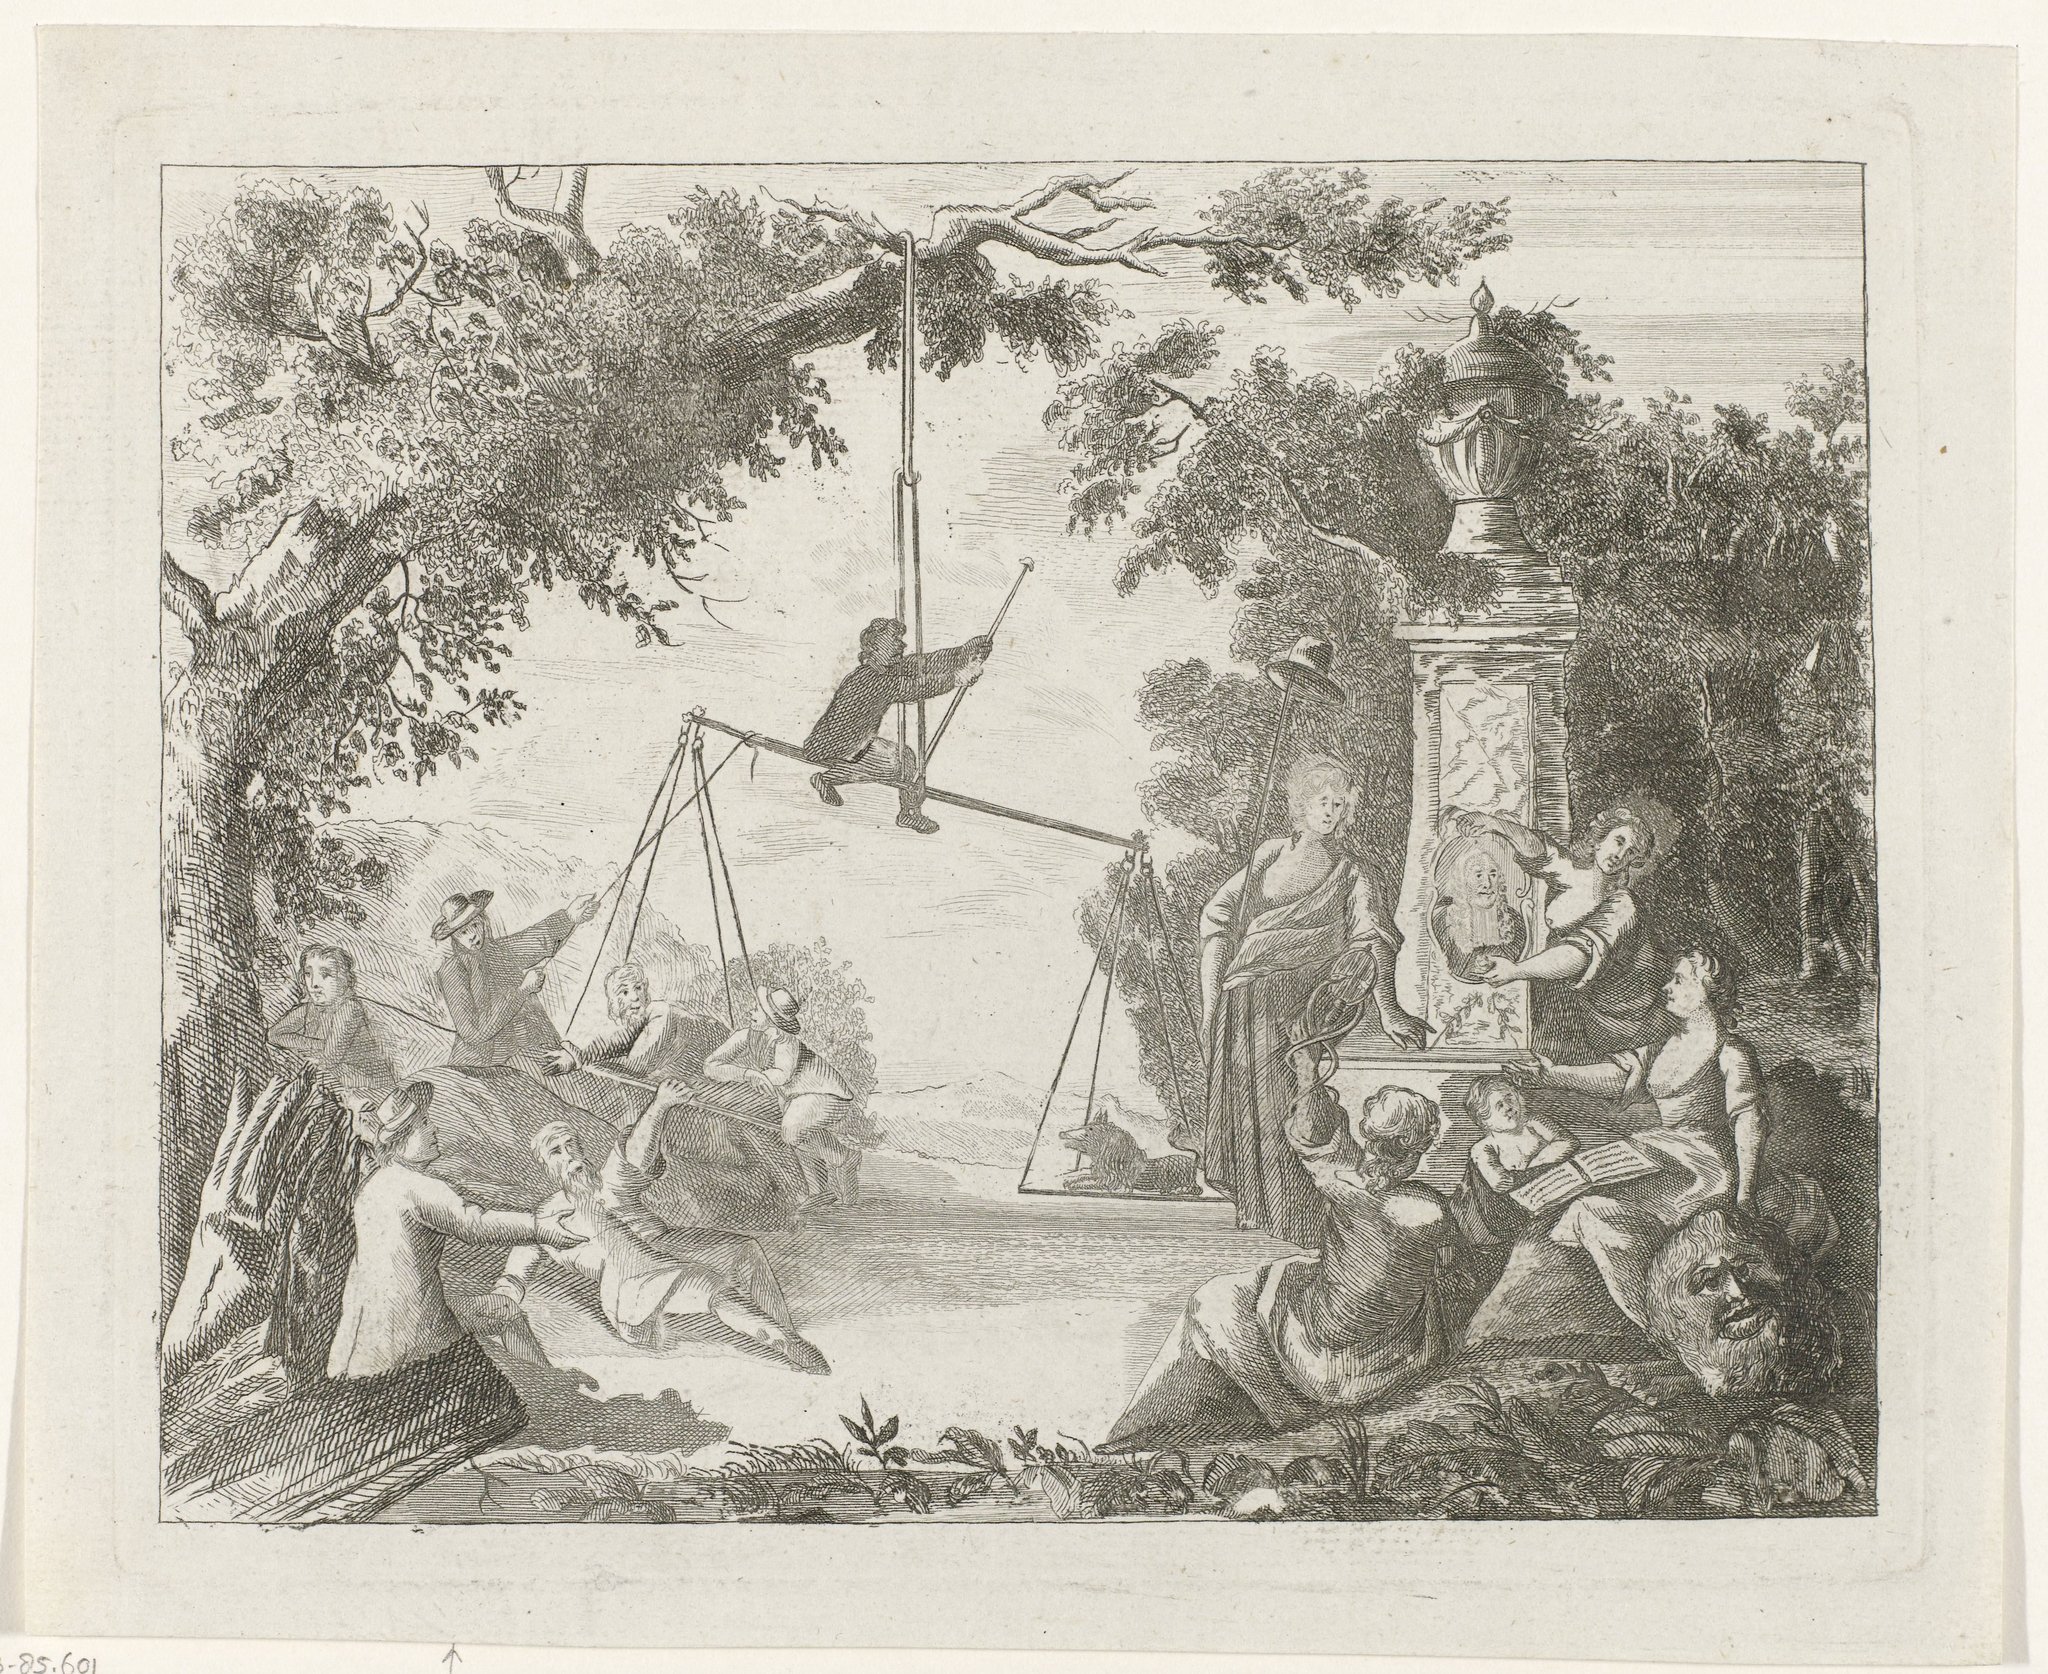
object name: print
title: Keeshond en Oranjeklanten op de weegschaal, 1787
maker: Anonymous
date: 1787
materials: paper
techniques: engraving, etching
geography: northern netherlands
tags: mayor, hendrik danielsz. hooft, prudence, 'prudentia'; 'prudenza' (ripa) ~ one of the four cardinal virtues, scales, allegorical representations ~ religion; 'religione', 'religione de ss. mauritio e lazaro', 'religione vera christiana' (ripa), freedom, liberty; 'libertà' (ripa) (+ abstract concept represented by female figure), patriots (1780-1795)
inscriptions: collector's mark: Lugt 2228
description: Allegorie waarin een kleine keeshond (patriotten) en Oranjeklanten op een weegschaal aan een boom worden gewogen. De keeshond doet de weegschaal doorslaan ondanks alle verwoede pogingen van de Oranjeklanten om het gewicht aan hun zijde te krijgen. Aan de zijde van de keeshond bevinden zich de Vrijheid, Voorzichtigheid, Liefde en Godsdienst bij een monument met een portret van de Amsterdamse burgemeester Hendrik Danielsz. Hooft, 1787. Bij de prent behoort een klein tekstblaadje.